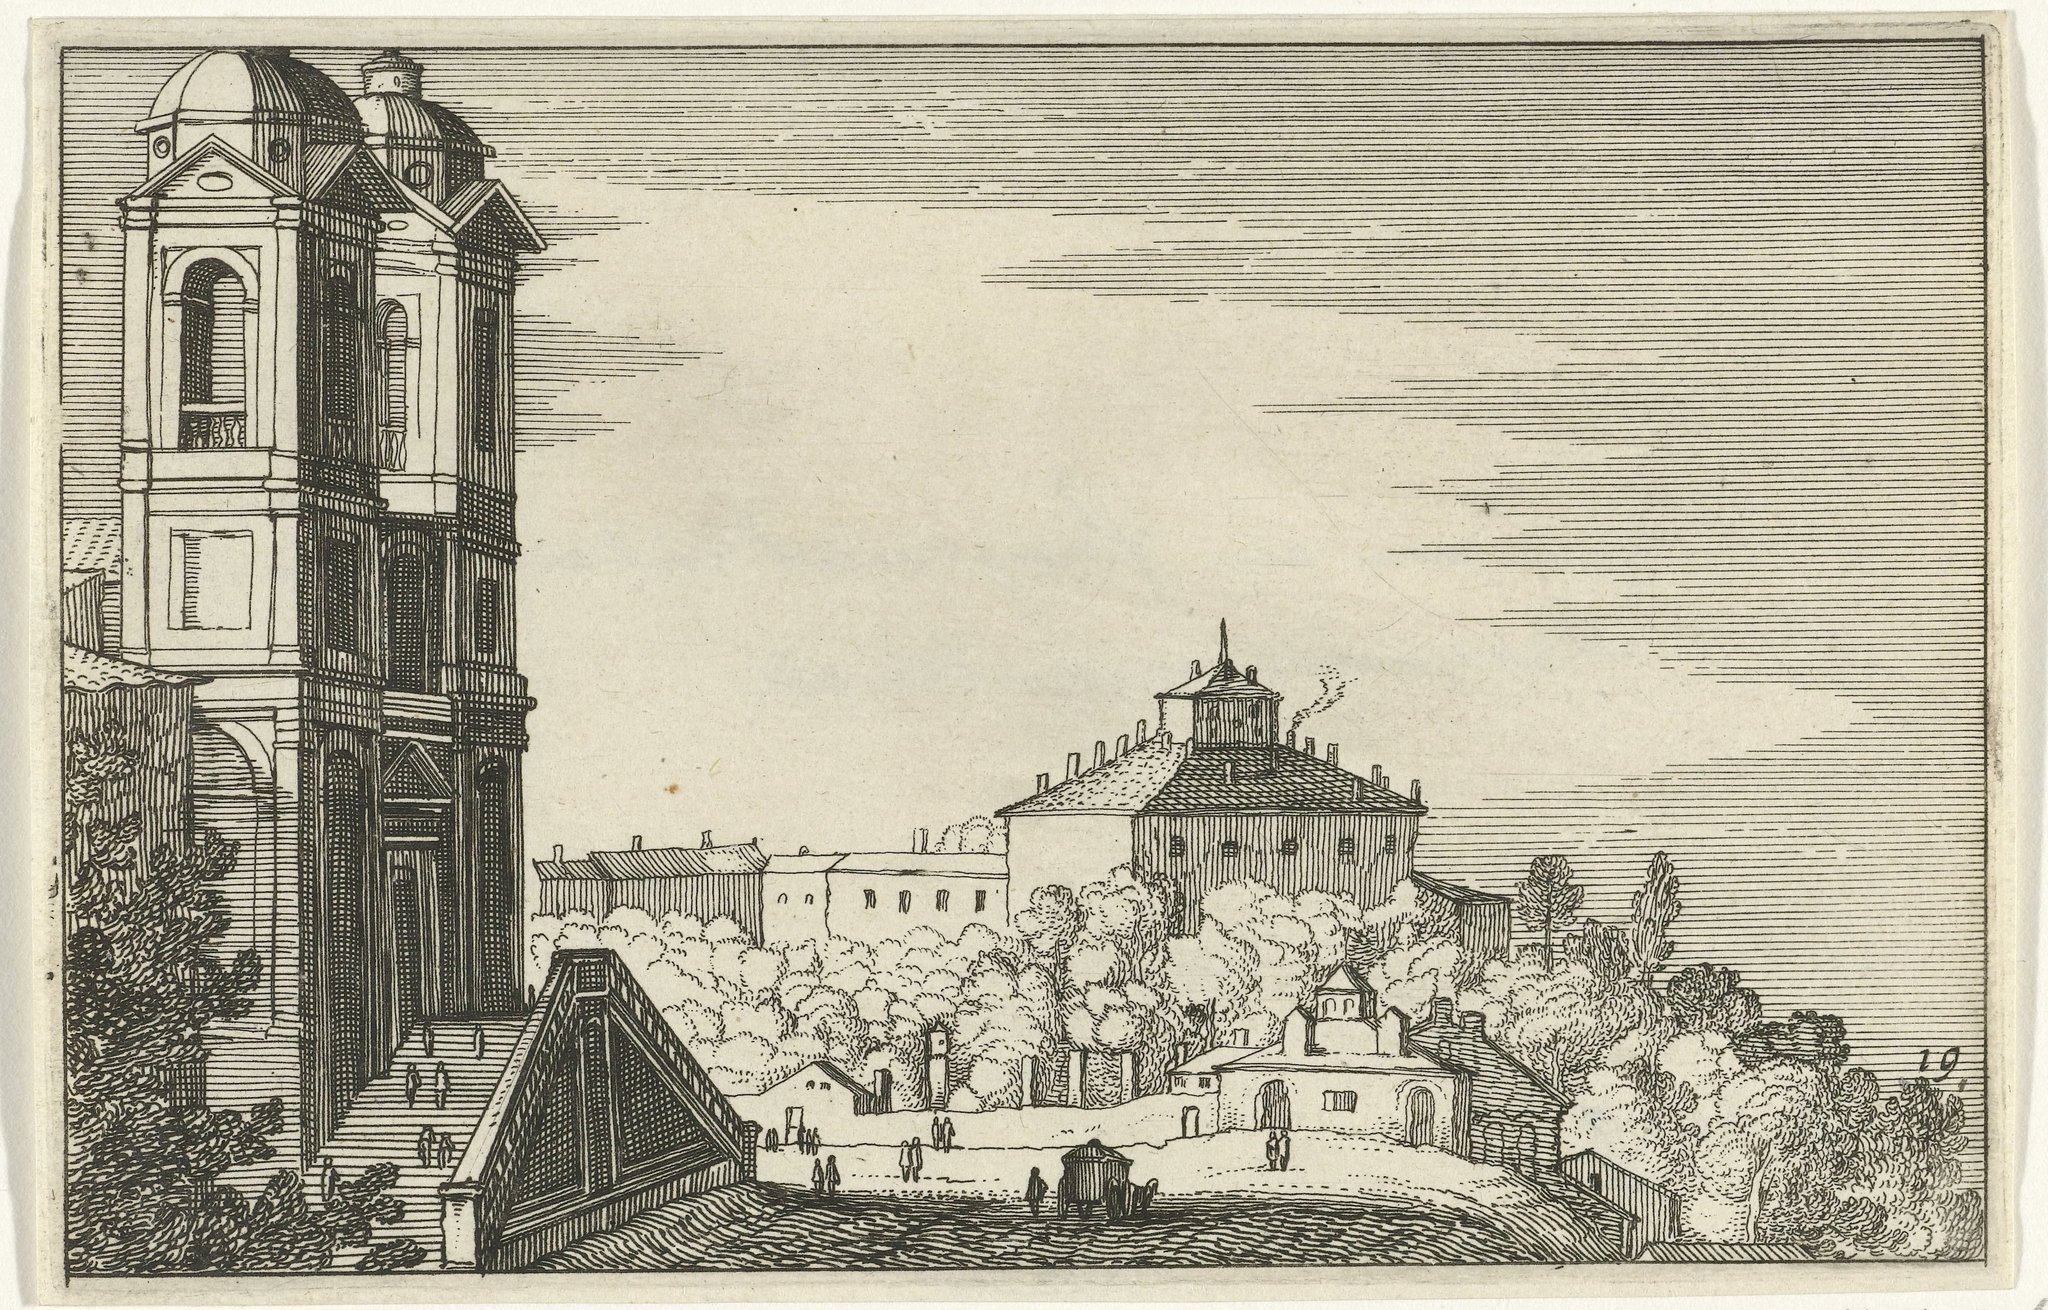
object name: print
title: Romeinse ruïnes en kustlandschappen (serie 1)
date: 1618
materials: paper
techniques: etching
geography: amsterdam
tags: church (exterior), rome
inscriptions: collector's mark: Lugt 2228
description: Links de kerk Trinità dei Monti in Rome. Daarnaast andere gebouwen en geboomte. Prent maakt deel uit van een serie Romeinse ruïnes en kustlandschappen naar een prentserie van Willem van Nieulandt.